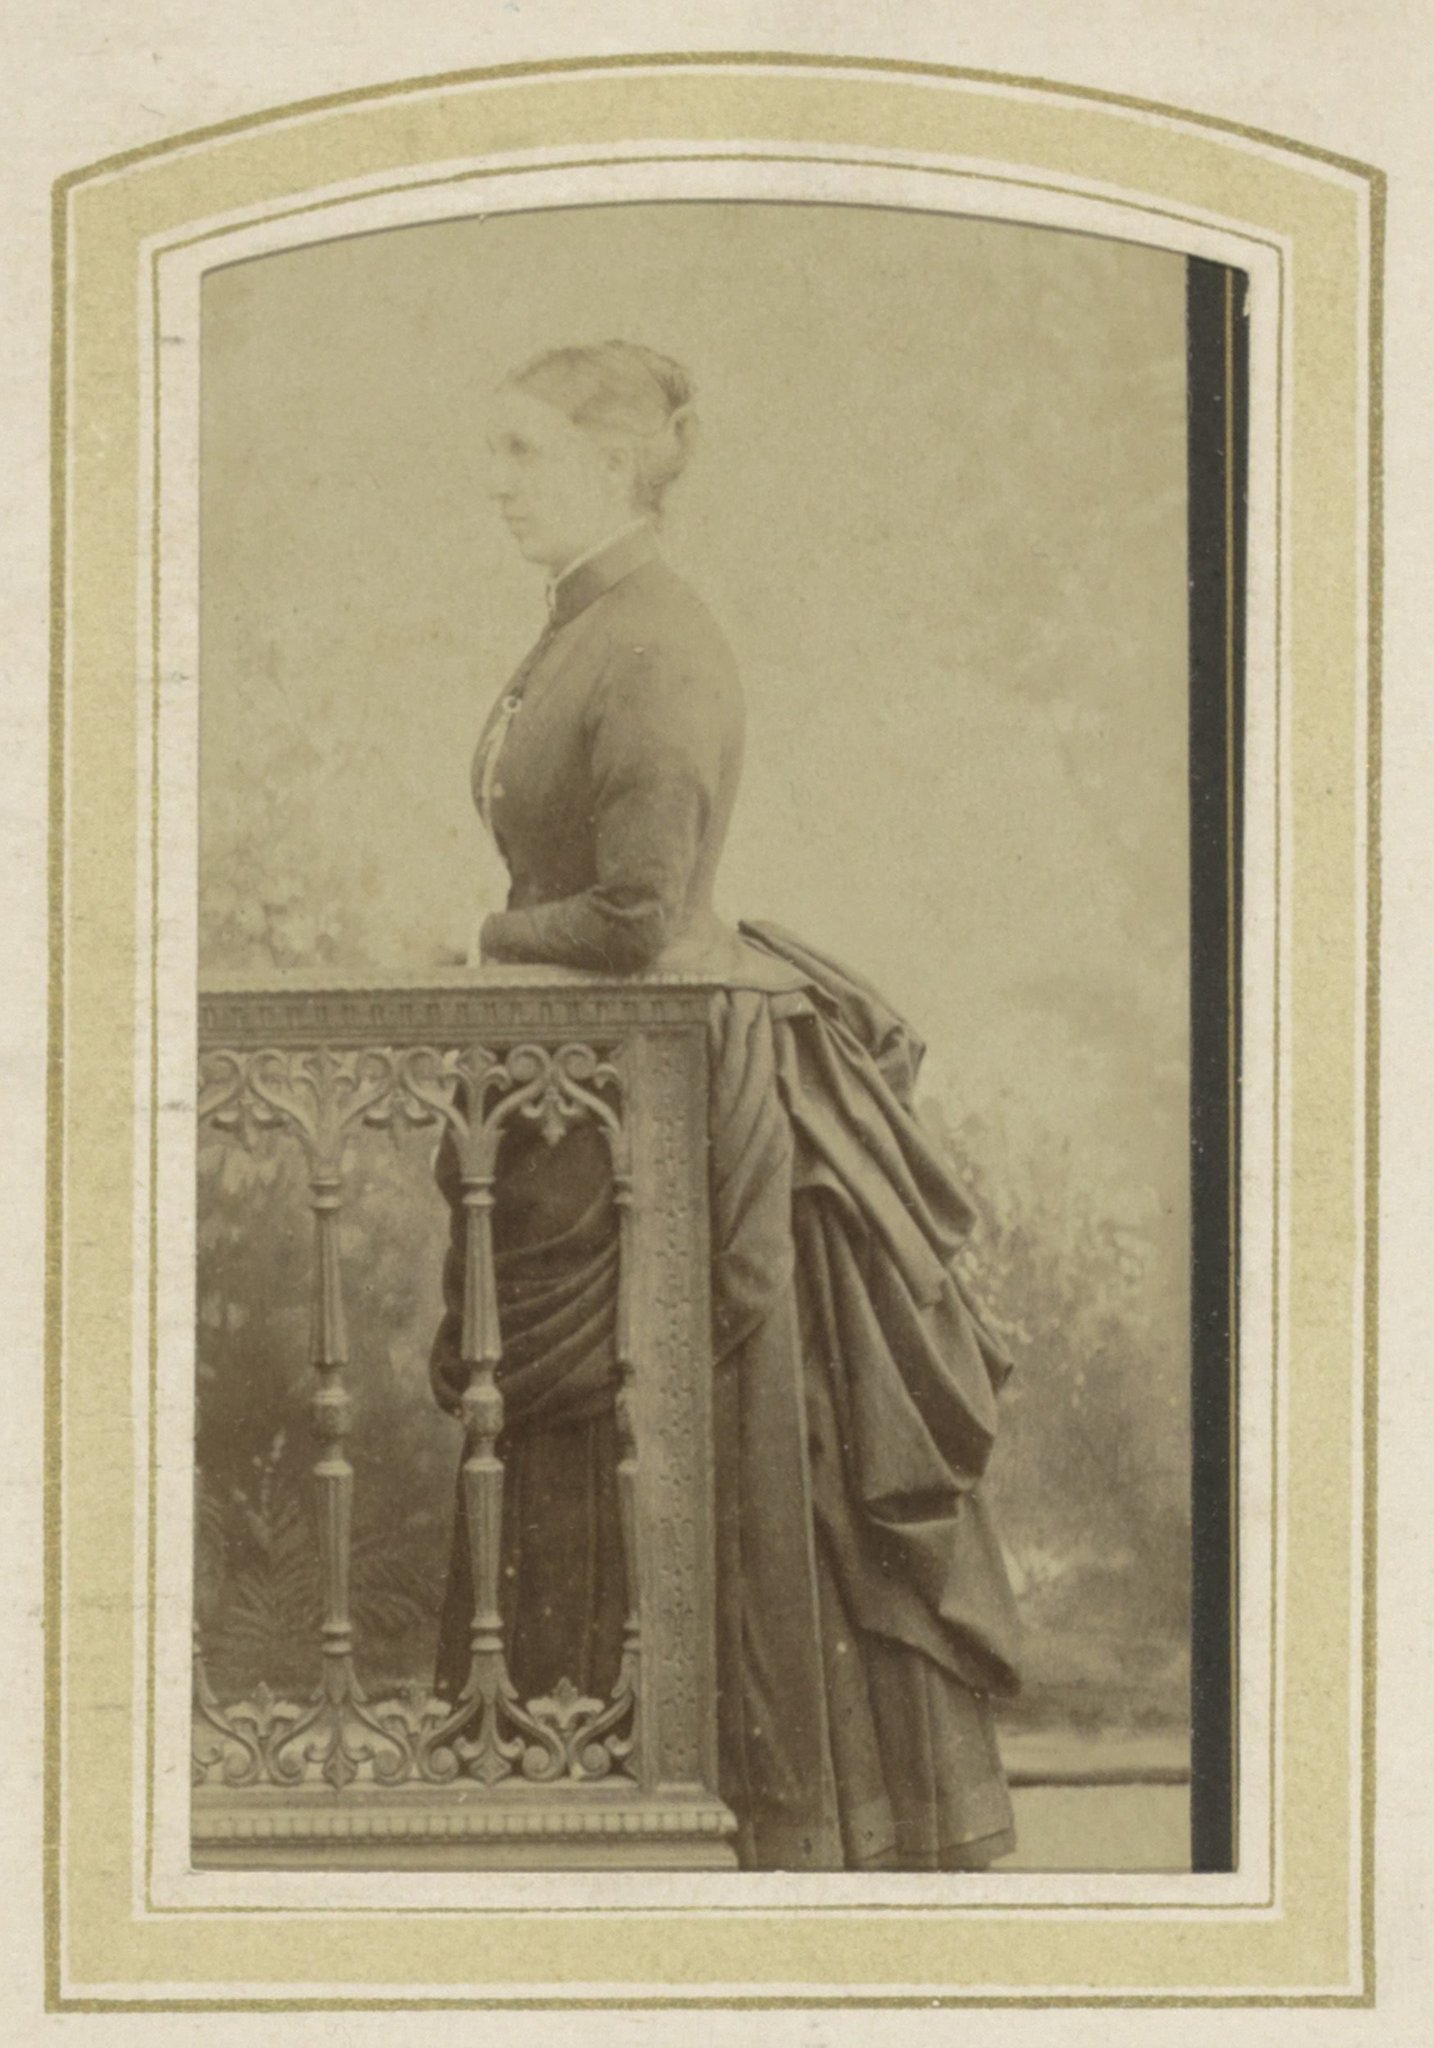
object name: carte de visite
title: Portret van een vrouw met een jurk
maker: Anonymous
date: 1860-1900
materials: cardboard, paper, photographic support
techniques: albumen print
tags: studio requisites ~ photographer, historical persons, hairdress, dress, gown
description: Onderdeel van Fotoalbum van een Nederlandse familie met 168 cartes-de-visite en kabinetfoto's.